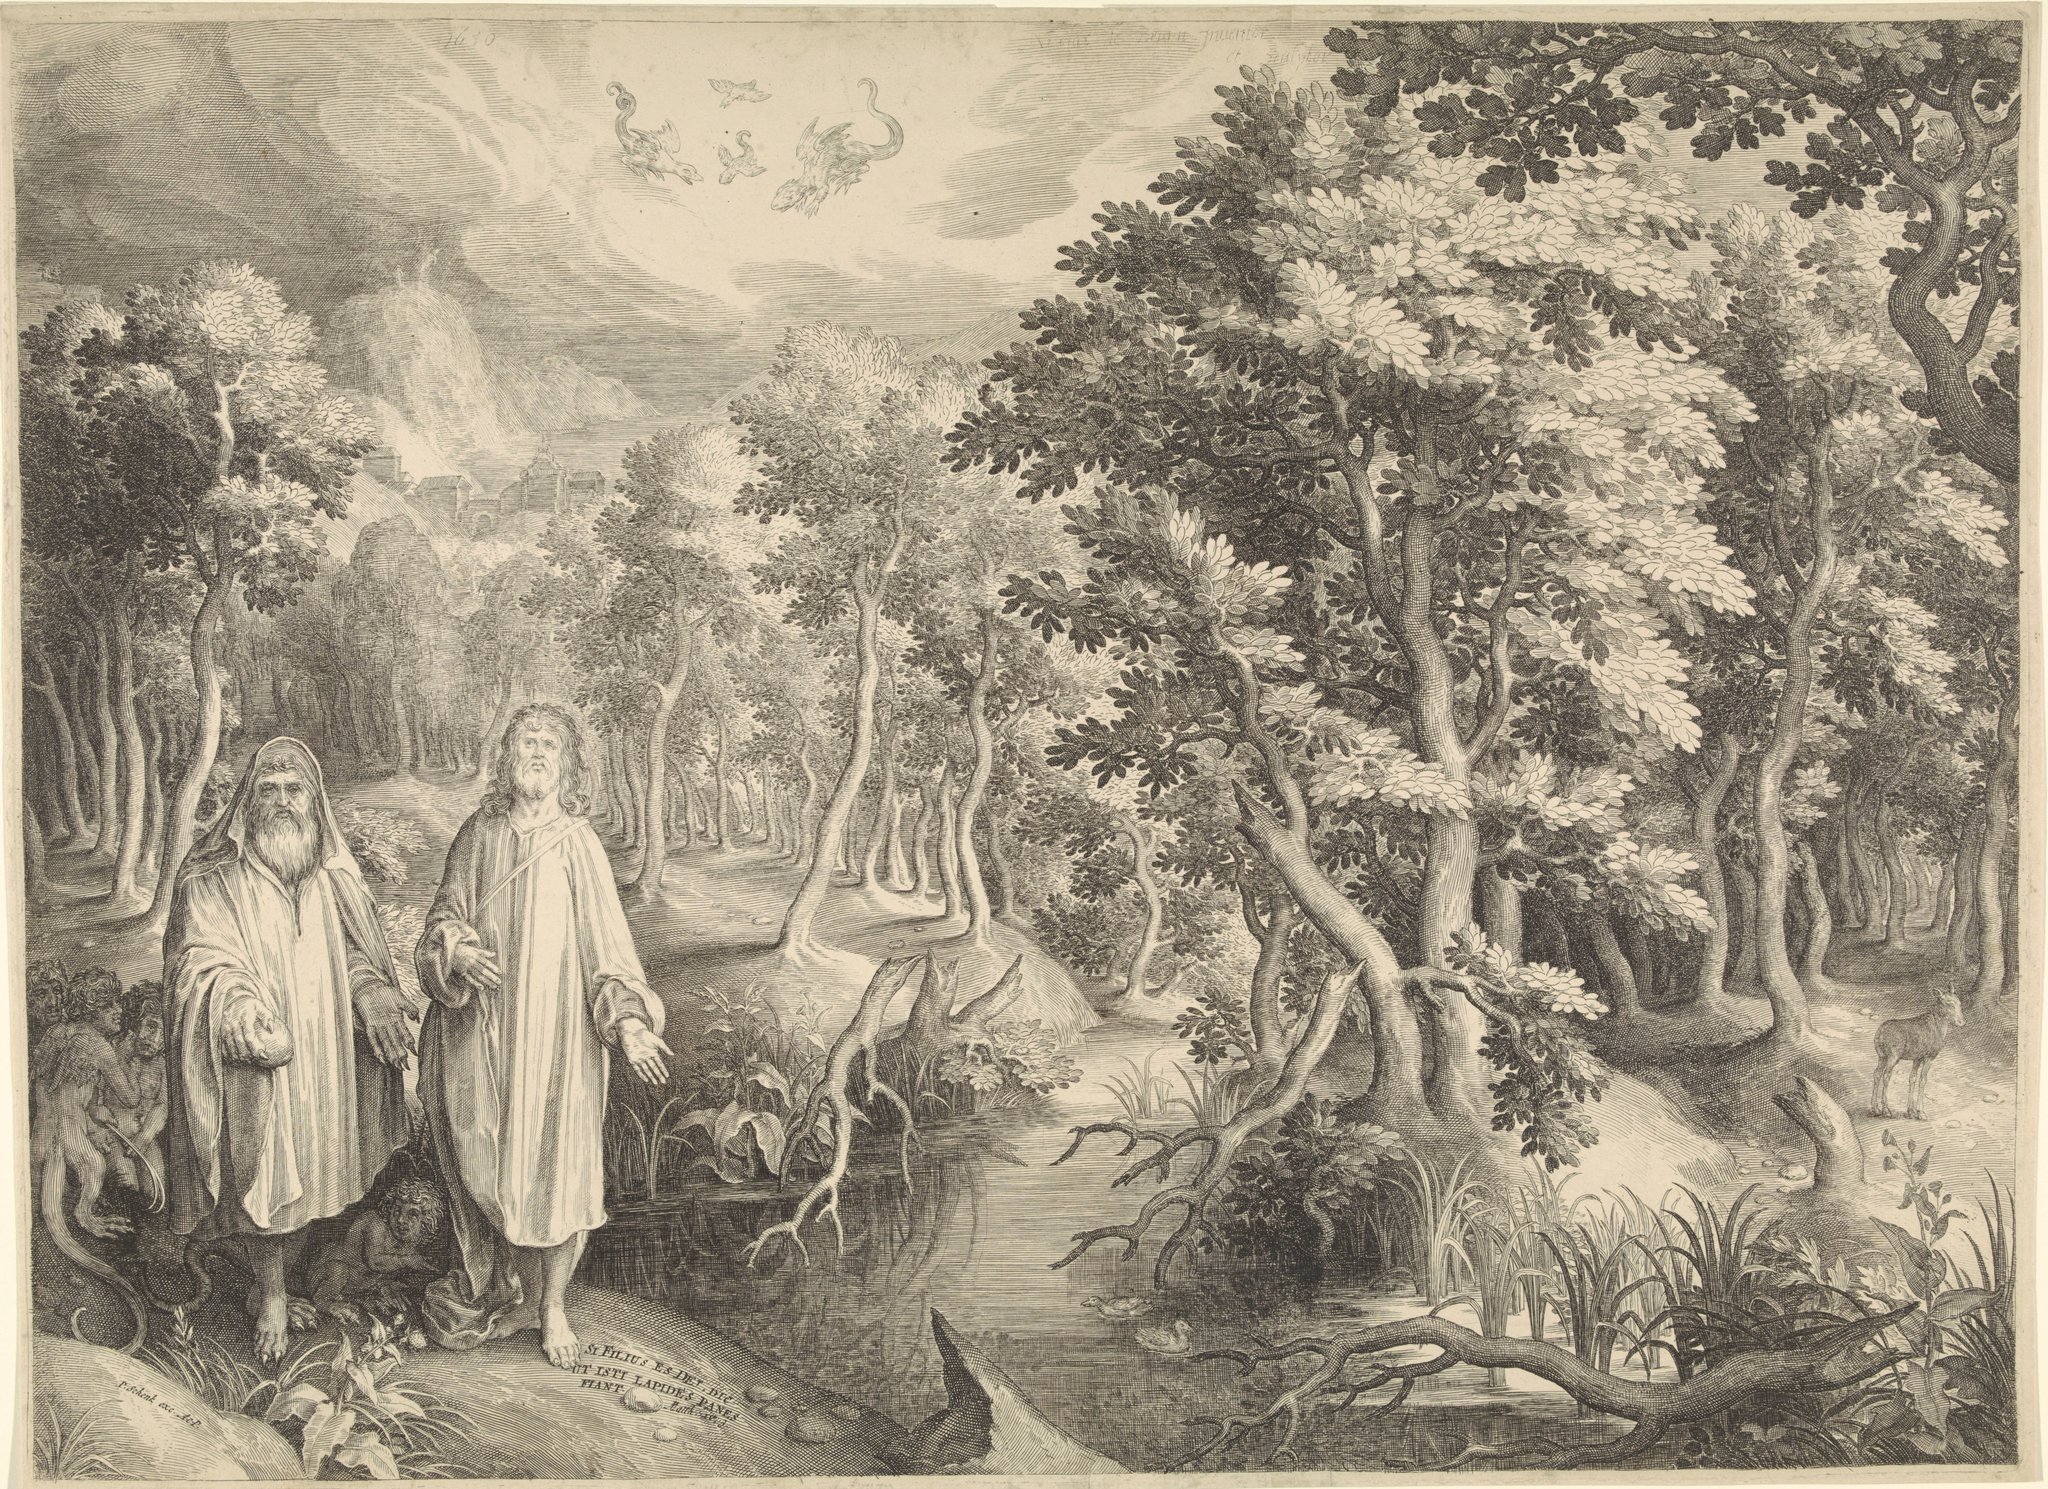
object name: print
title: Verzoeking van Christus in de woestijn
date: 1650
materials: paper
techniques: engraving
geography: amsterdam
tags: 'command these stones to become loaves of bread' ~ temptation of christ in the wilderness, 'all these will i give you' (= the glory of the world) ~ temptation of christ in the wilderness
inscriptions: collector's mark: Lugt 2228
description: Een duivel toont Christus een steen en vraagt hem de steen in brood te veranderen als teken van zijn goddelijkheid. Rond de duivel allerlei kleine demonen. In de lucht vliegen draken. Op een achterliggende bergtop toont de duivel Christus alle koninkrijken van de wereld om hem te verleiden. De prent heeft een Latijns onderschrift met een citaat uit Matteüs 4.